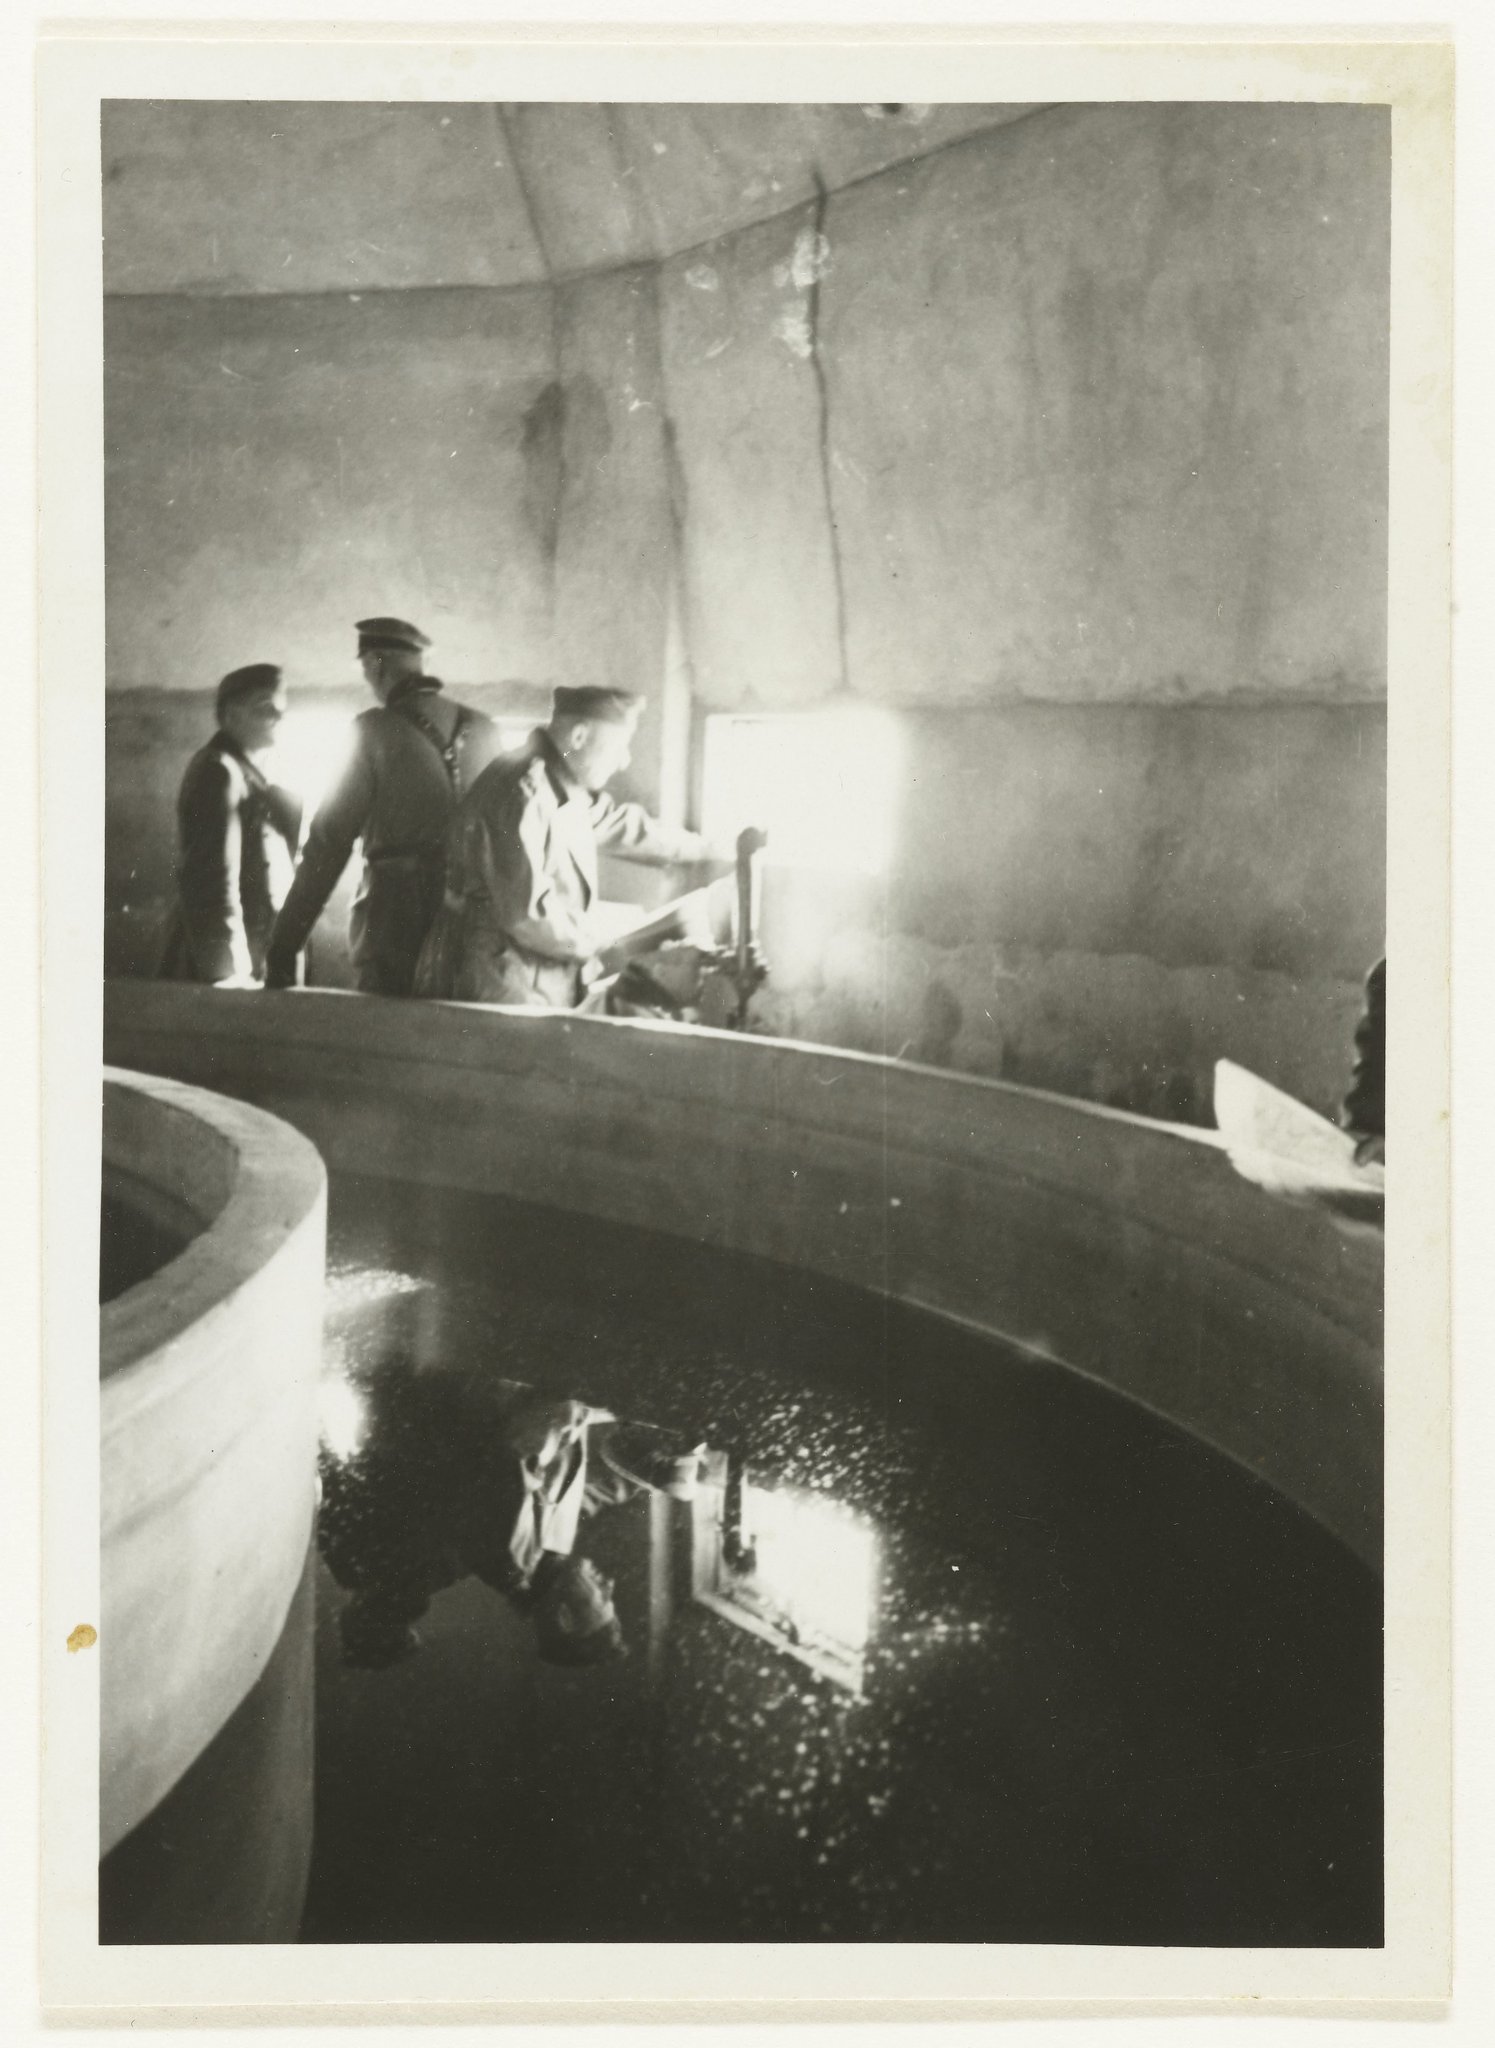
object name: photograph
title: Wehrmacht installeert uitkijkpost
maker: Anonymous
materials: photographic support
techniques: gelatin silver print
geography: dongen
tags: water tower, occupation ~ war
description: De Wehrmacht heeft een uitkijkpost geinstalleerd in de watertoren. Vooraan is water te zien, links drie militairen met een verrekijker die door een gat steekt. In het water wordt een militair weerspiegeld.